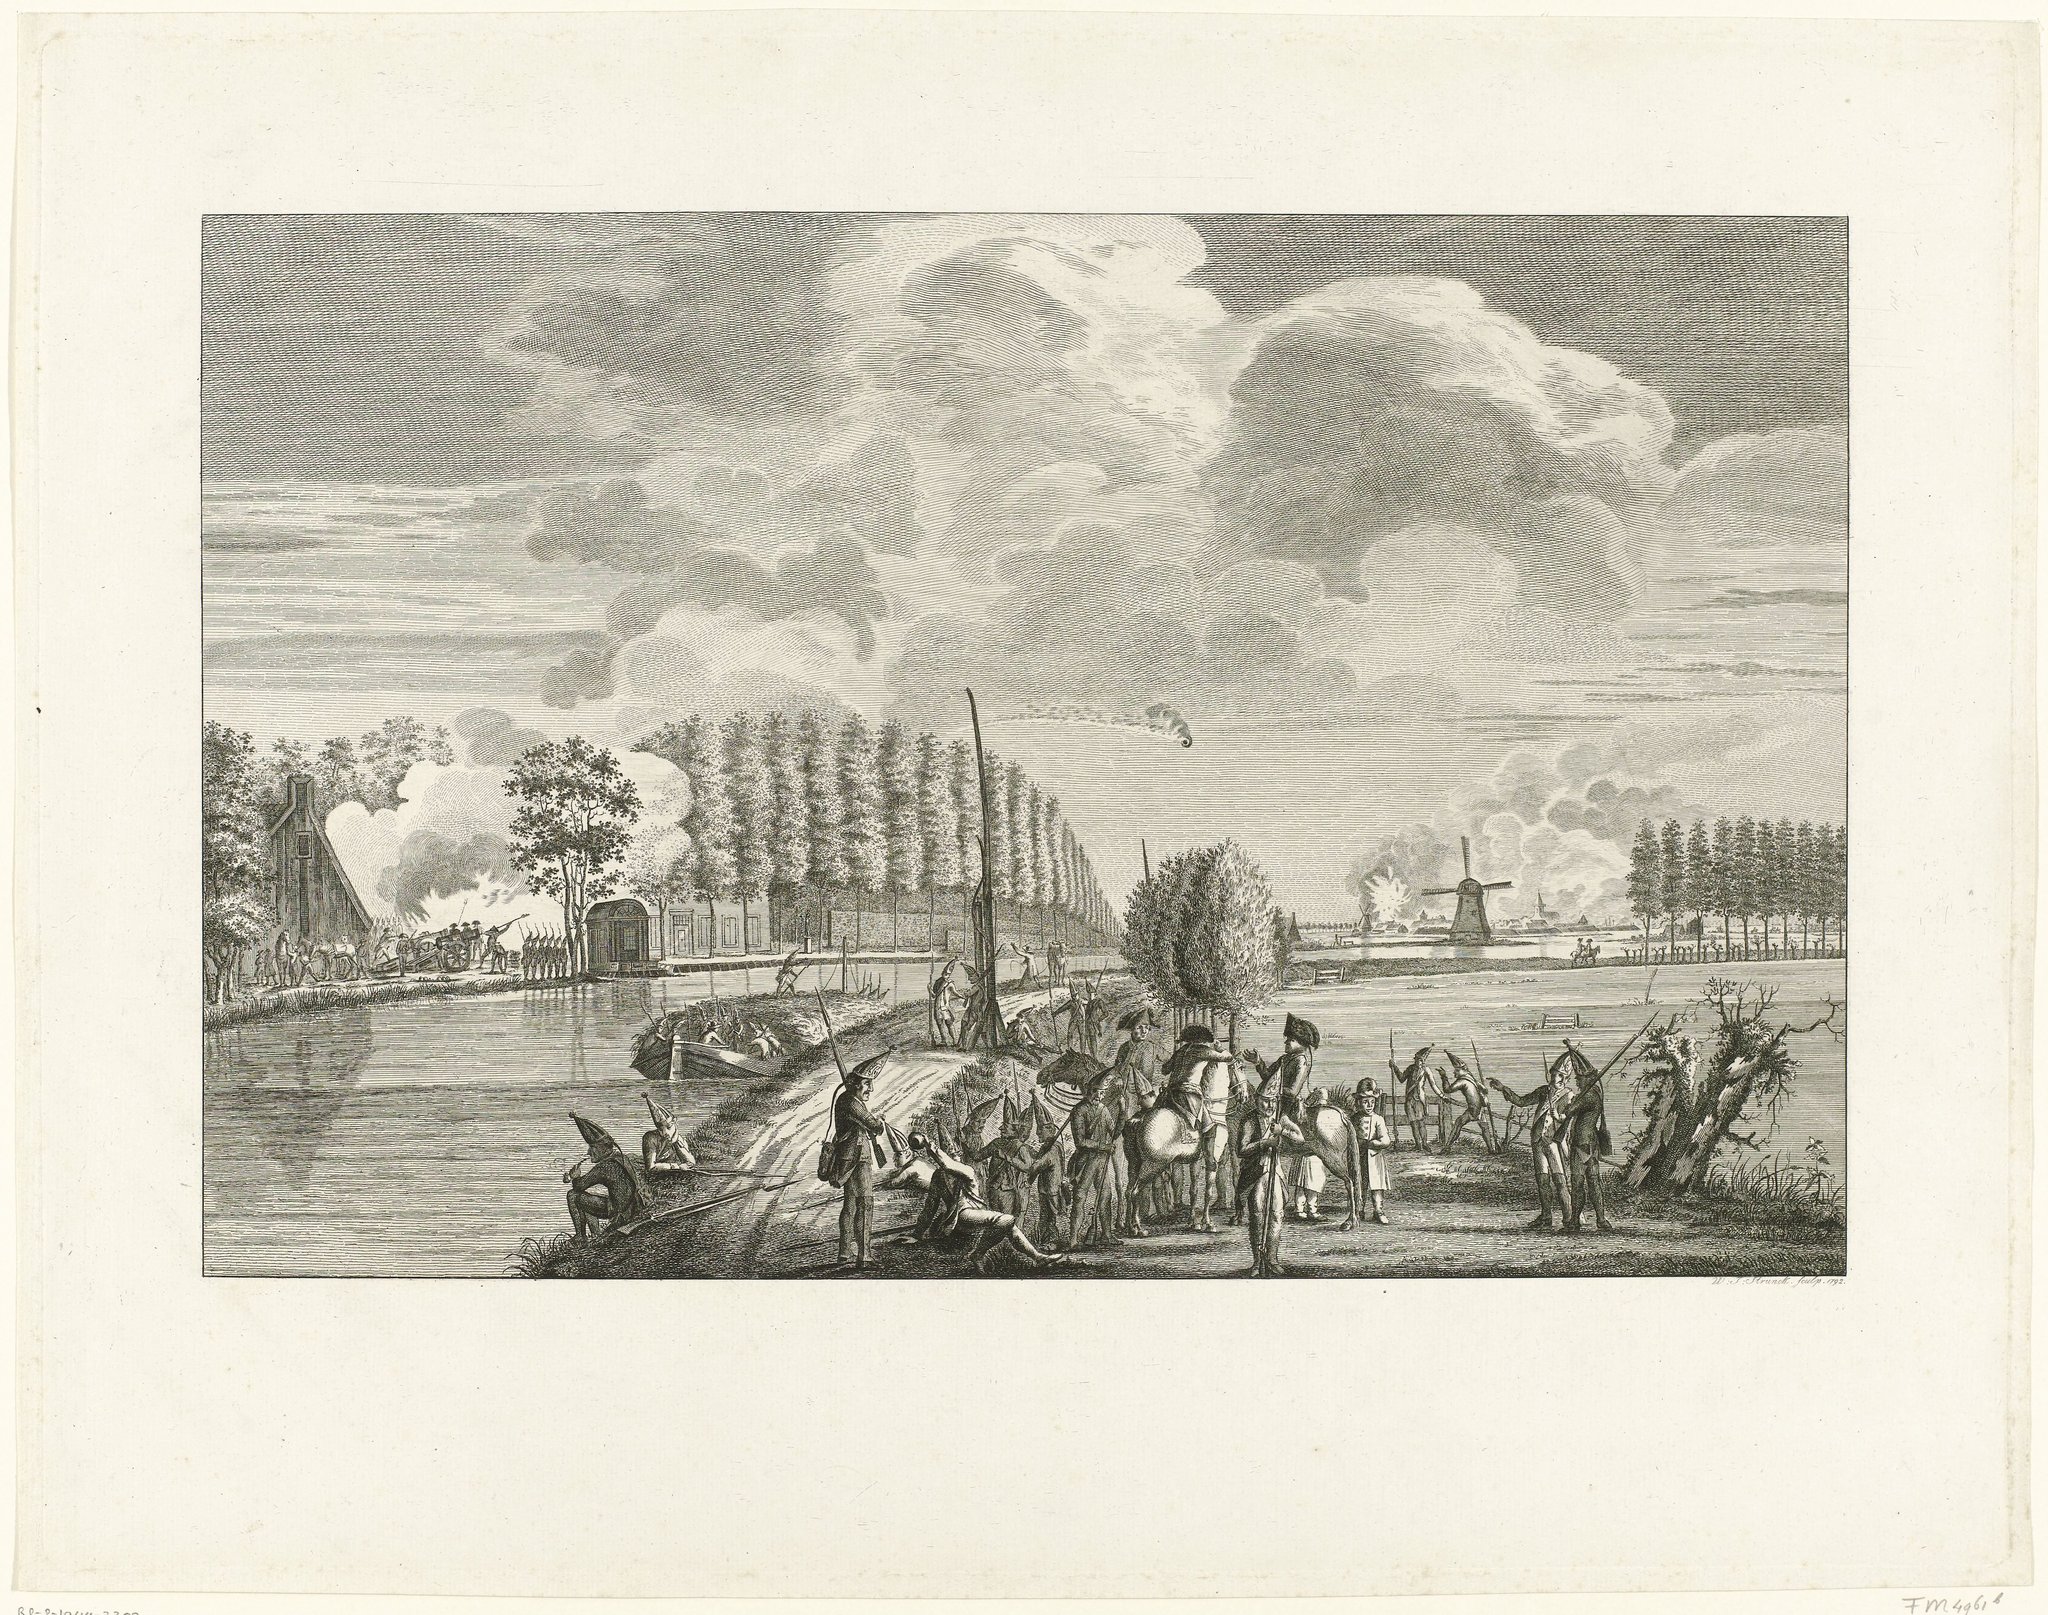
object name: print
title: Gevechten met de Pruisische troepen rond Amsterdam in 1787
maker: jacob willem strunck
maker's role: print maker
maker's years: 1766-1813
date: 1792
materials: paper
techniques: engraving, etching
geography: northern netherlands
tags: berlin, bombardment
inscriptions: collector's mark: Lugt 2228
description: Aanval op de stad Muiden door de Pruisische troepen onder generaal Friedrich Adolf von Kalckreuth, verdedigd door Amsterdamse schutters onder kolonel Mattha, 1 oktober 1787. Op de voorgrond de Pruisen, op de achtergrond het bombardement van de stad. Onderdeel van een groep van zeven prenten van de gevechten met de Pruissische troepen rond Amsterdam in 1787.